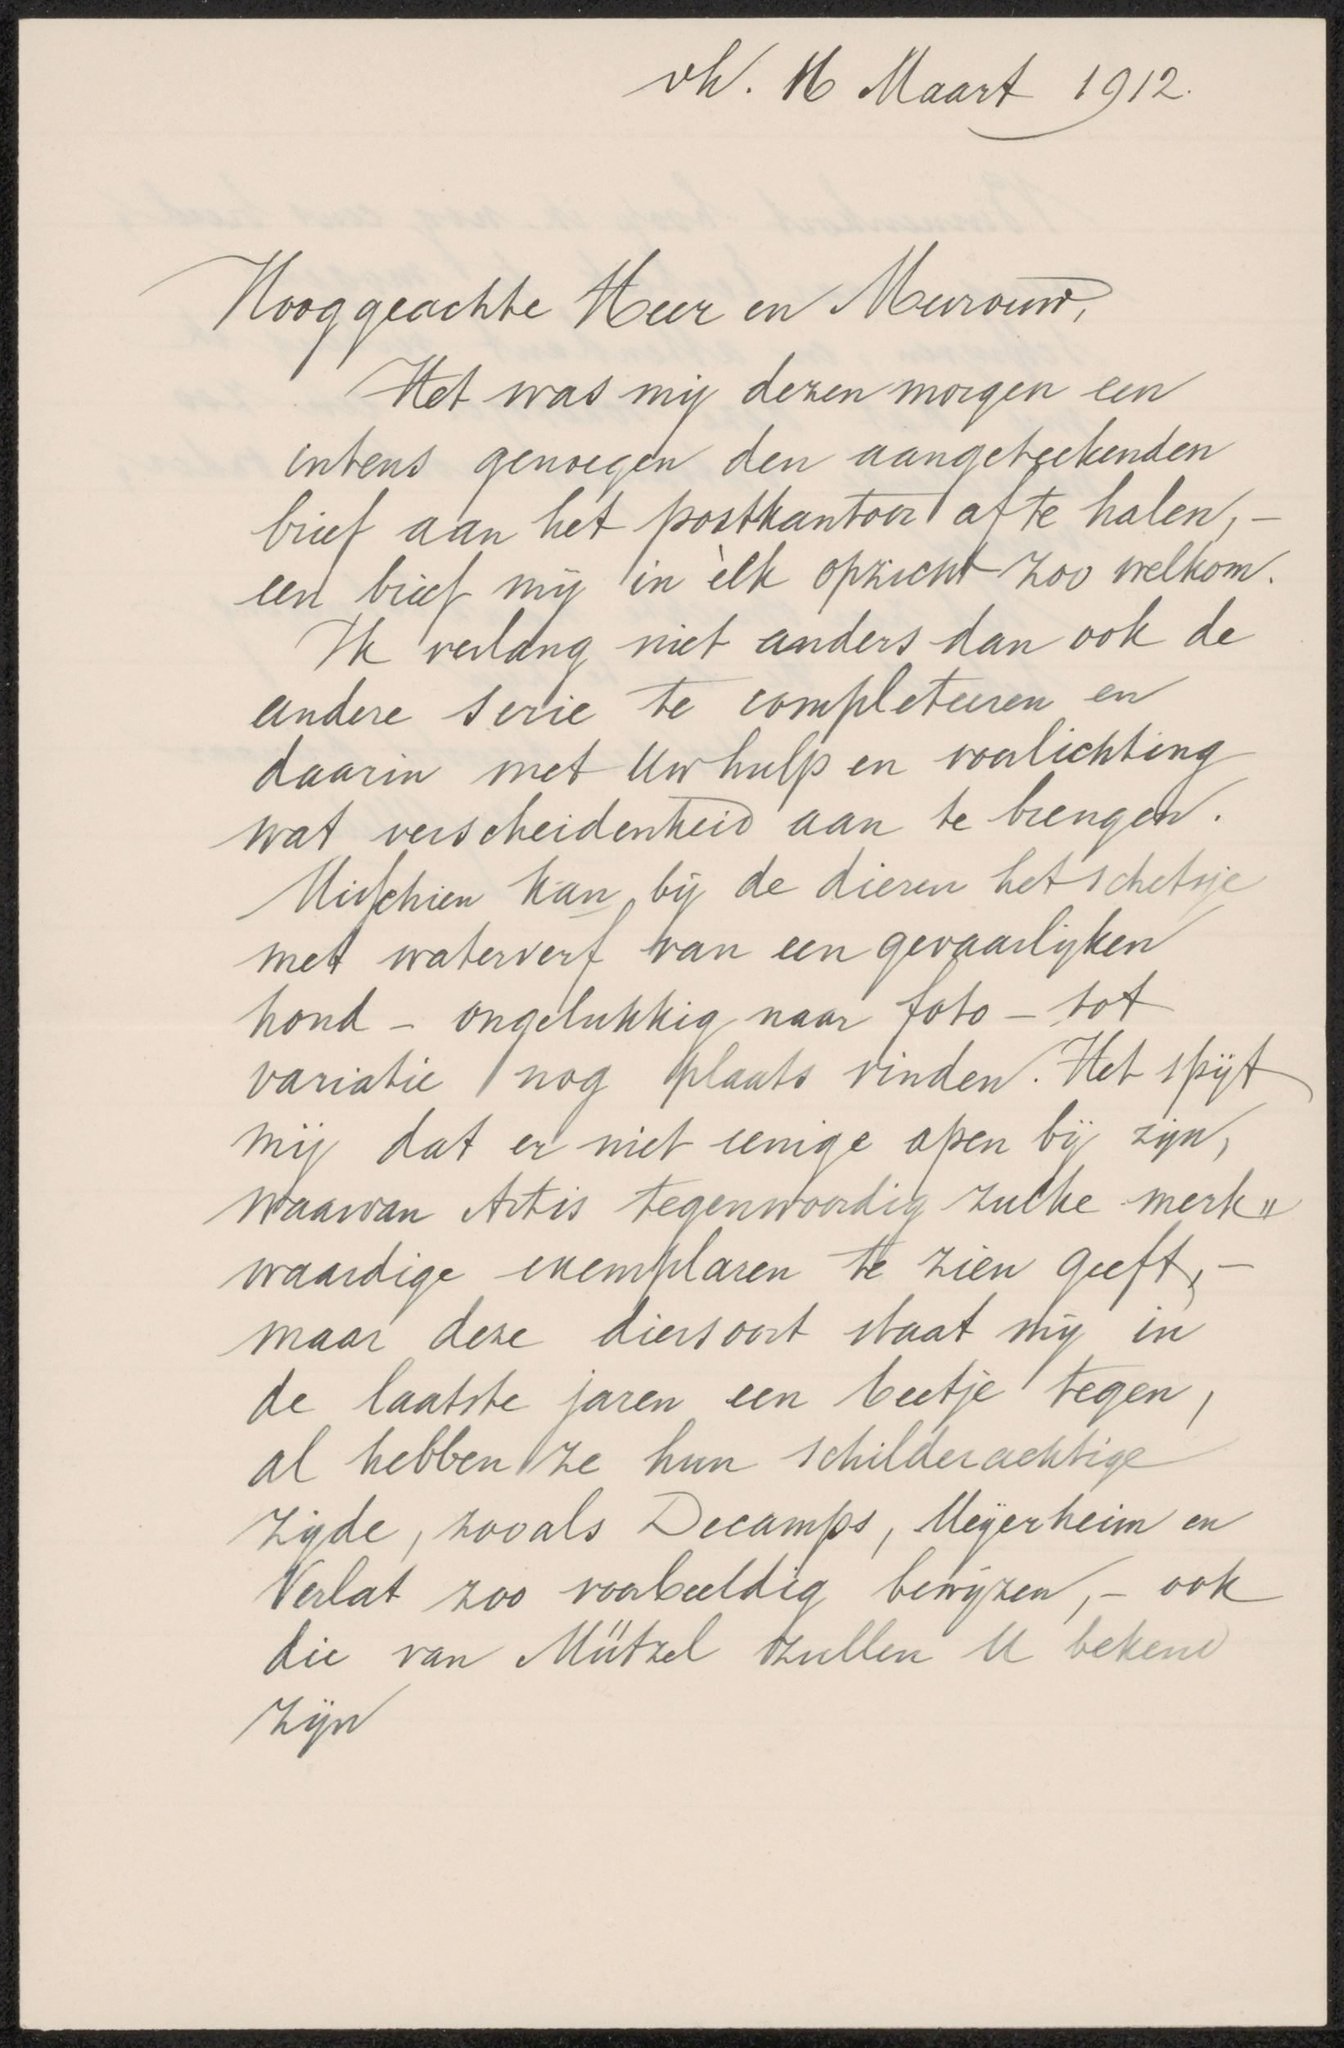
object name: letter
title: Brief aan Max Wilhelm Carl Weber en Anne Antoinette Weber-Van Bosse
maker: august allebé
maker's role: draughtsman, print maker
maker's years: 1838-1927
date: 1912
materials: ink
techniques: pen, writing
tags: anne antoinette weber-van bosse, paris, draughtsman, alexandre-gabriel decamps, antwerp, painter, print maker, charles verlat, berlin, paul friedrich meyerheim, drawing